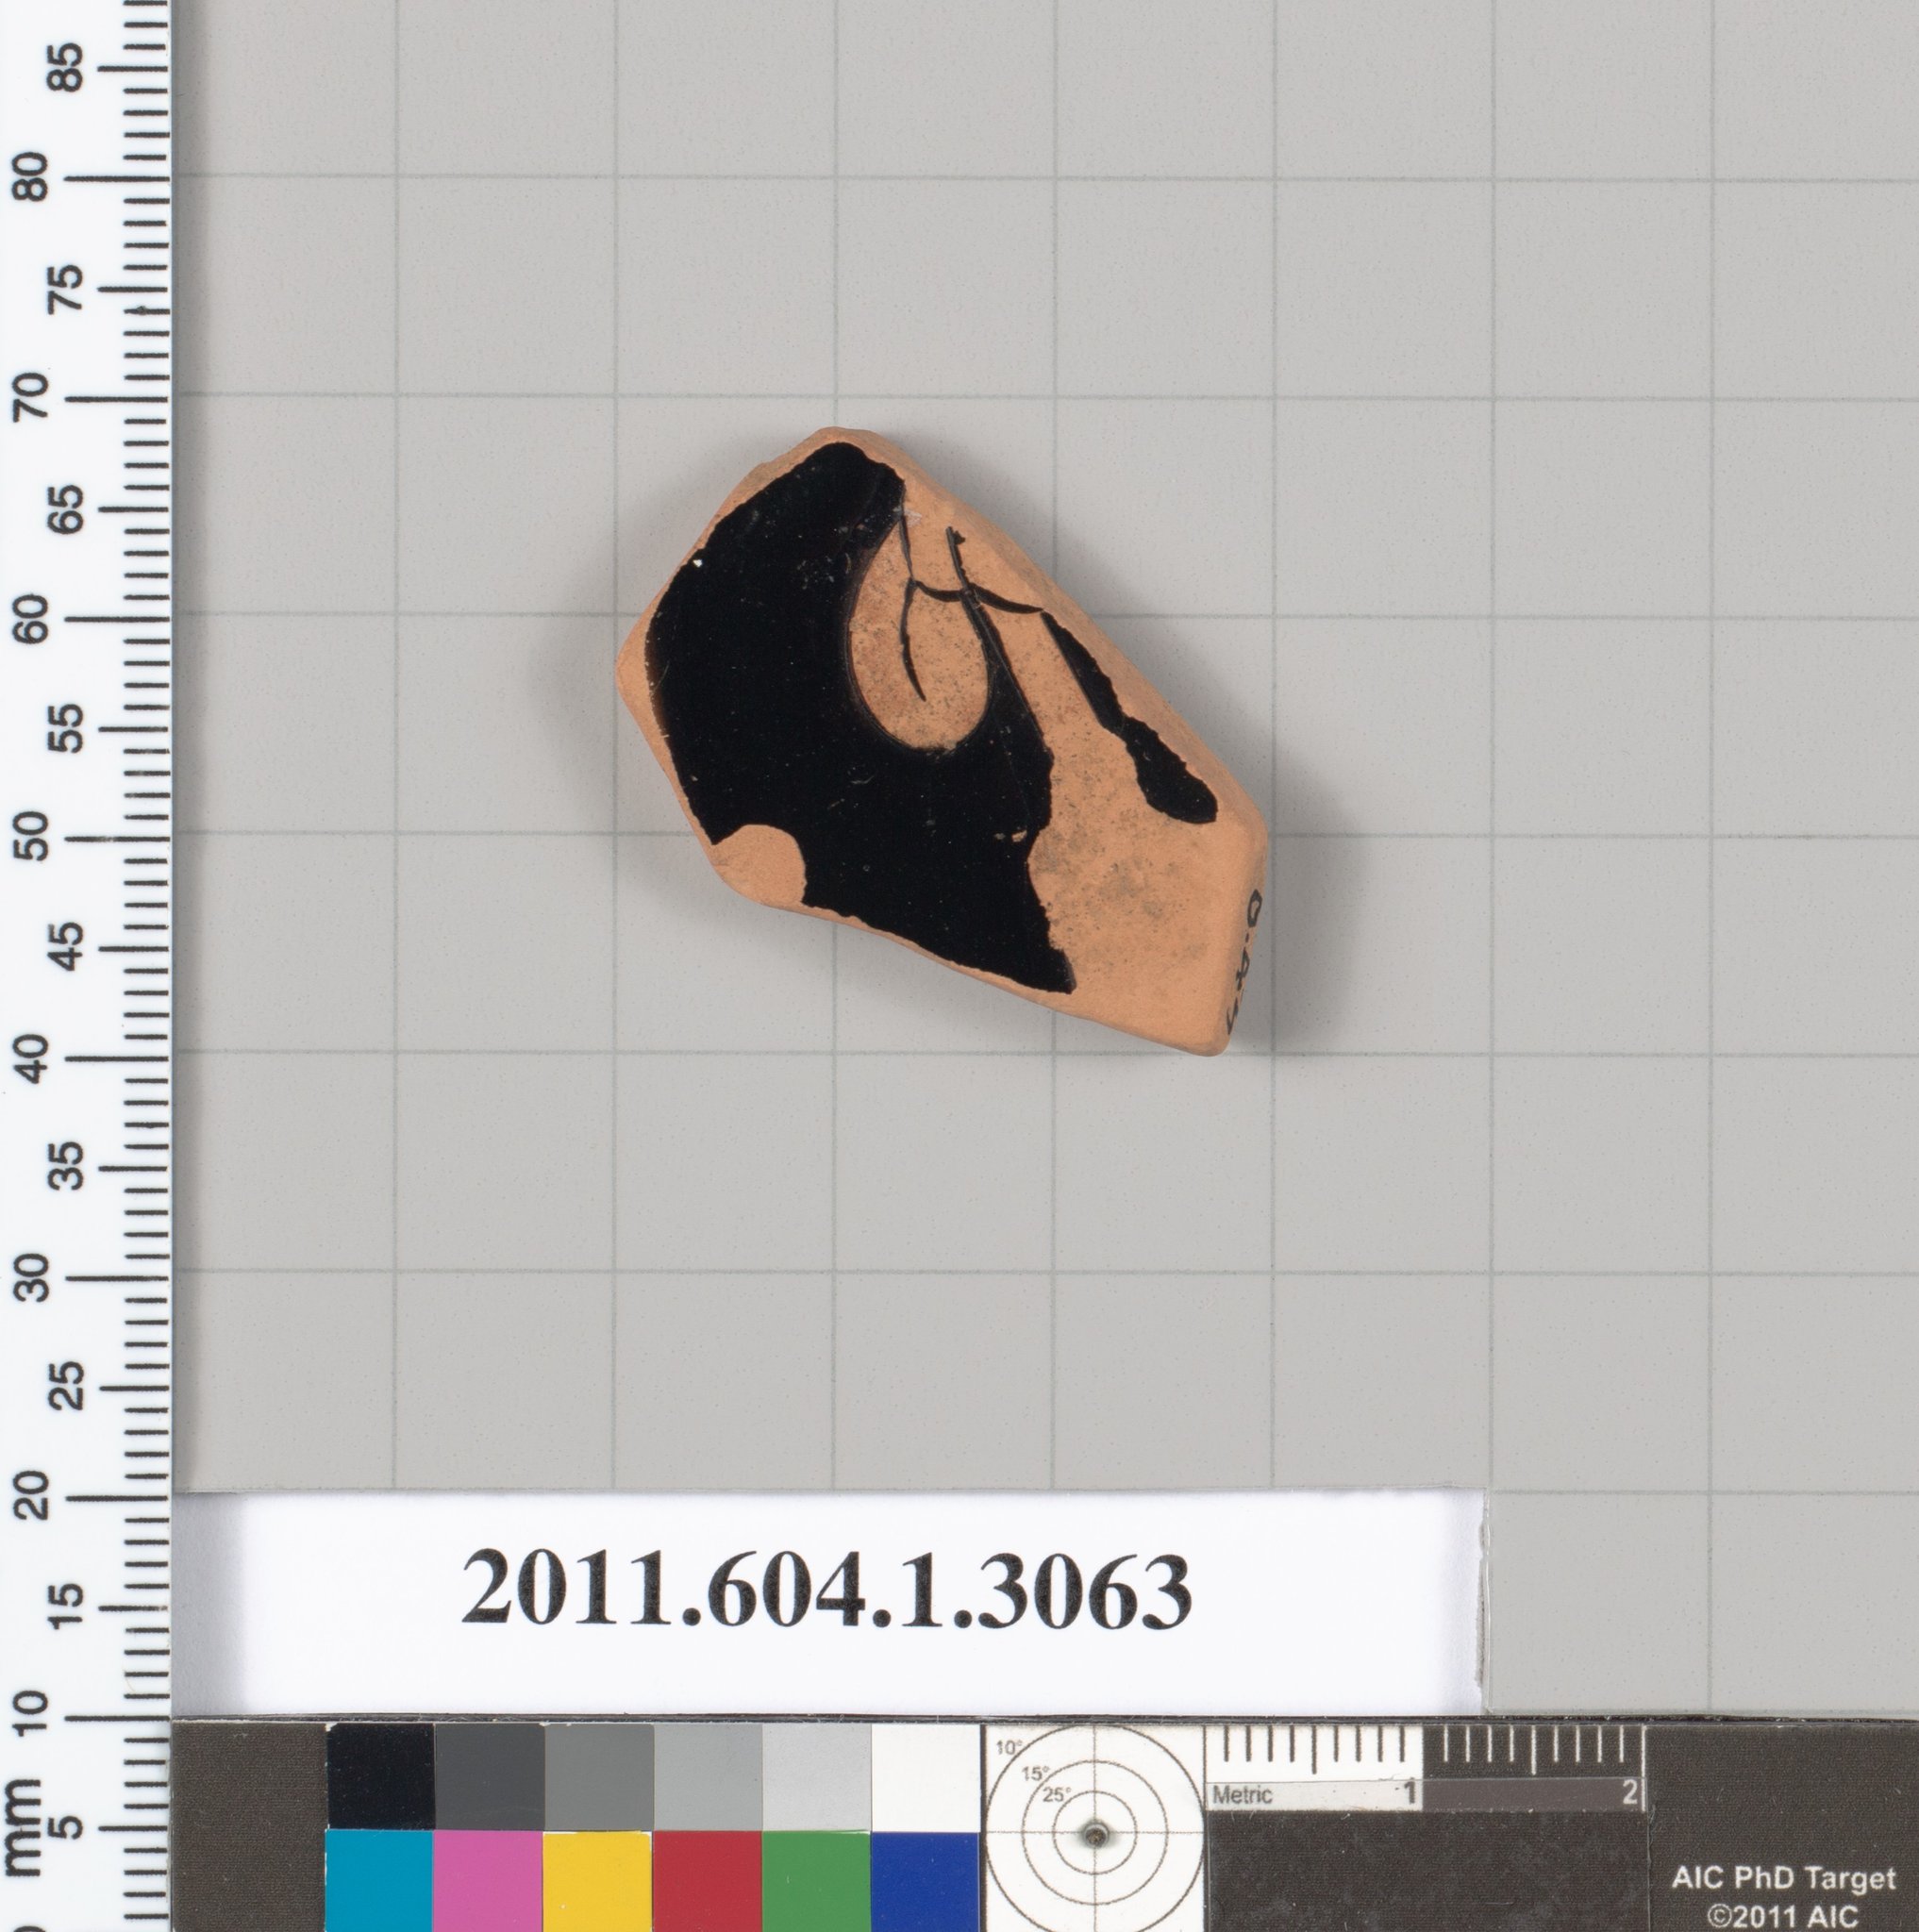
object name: kylix fragment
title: Terracotta fragment of a kylix (drinking cup)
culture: greek, attic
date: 490-480 BCE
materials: terracotta